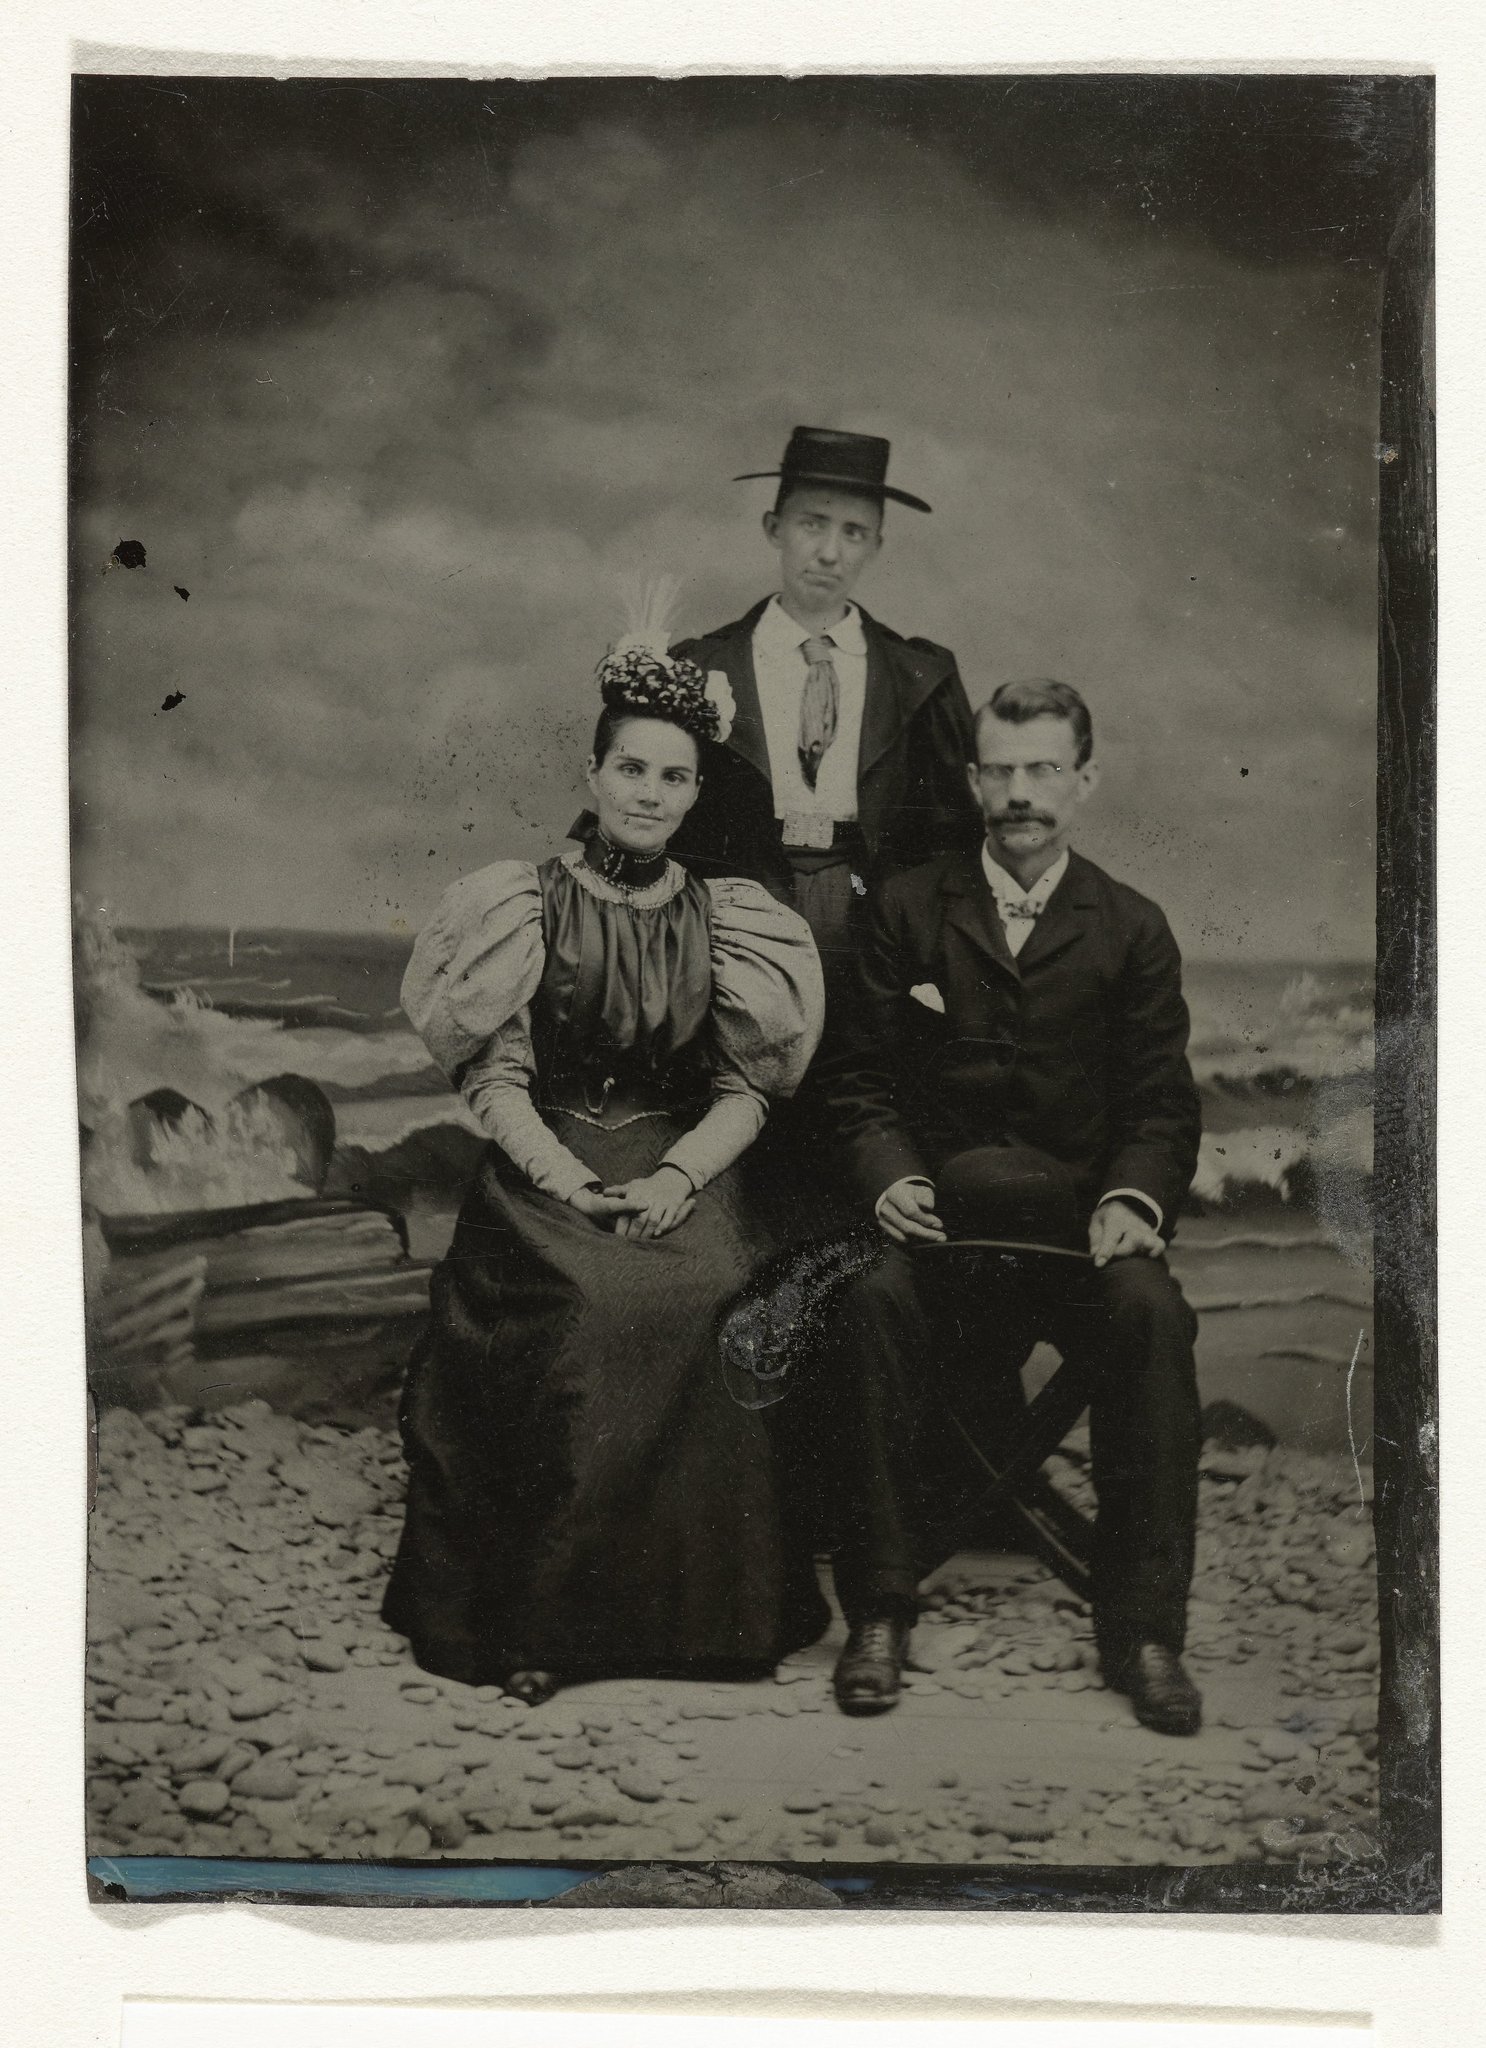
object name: photograph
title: Portret van twee mannen en een vrouw voor een geschilderd achtergronddoek met zee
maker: Anonymous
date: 1880-1910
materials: metal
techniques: ferrotyping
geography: united states